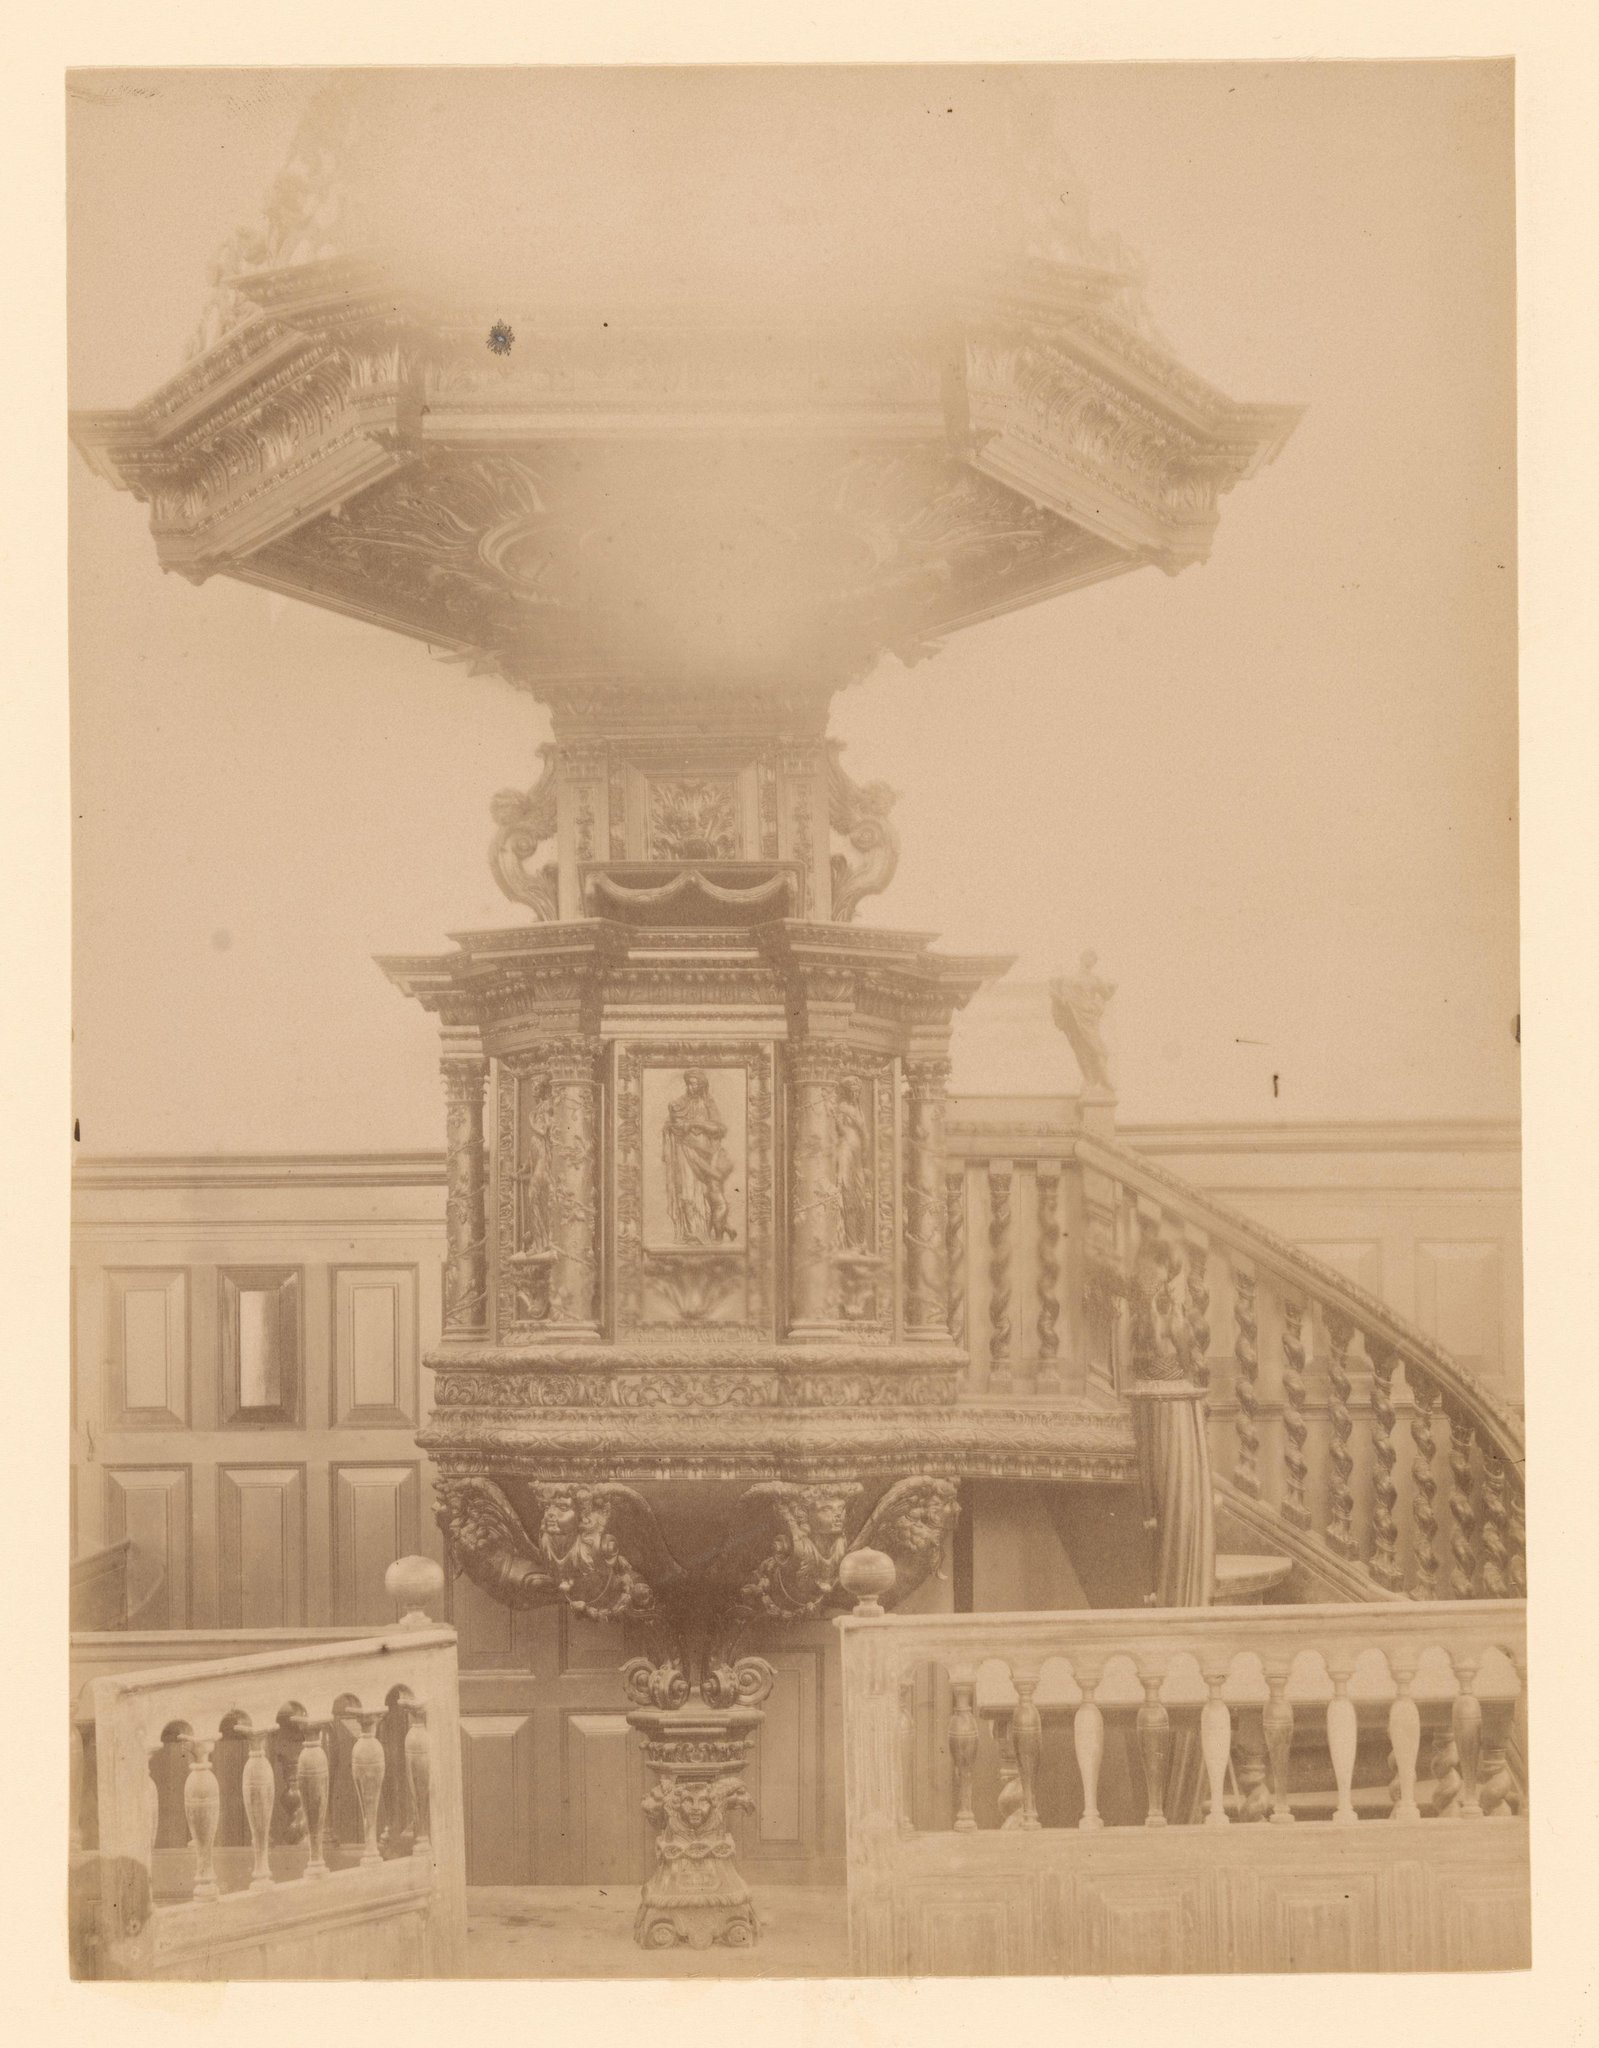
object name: photograph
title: Preekstoel in de Van Harenskerk te Sint-Annaparochie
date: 1898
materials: cardboard, photographic support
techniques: albumen print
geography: van harenskerk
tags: pulpit, ambo, chancel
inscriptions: annotation: ‘St. Annaparochie/ gem. Het Bilt’, annotation: ‘Preekstoel in de N.H. Kerk / te St Anne parochie / Frieschland / Nov. 1898’